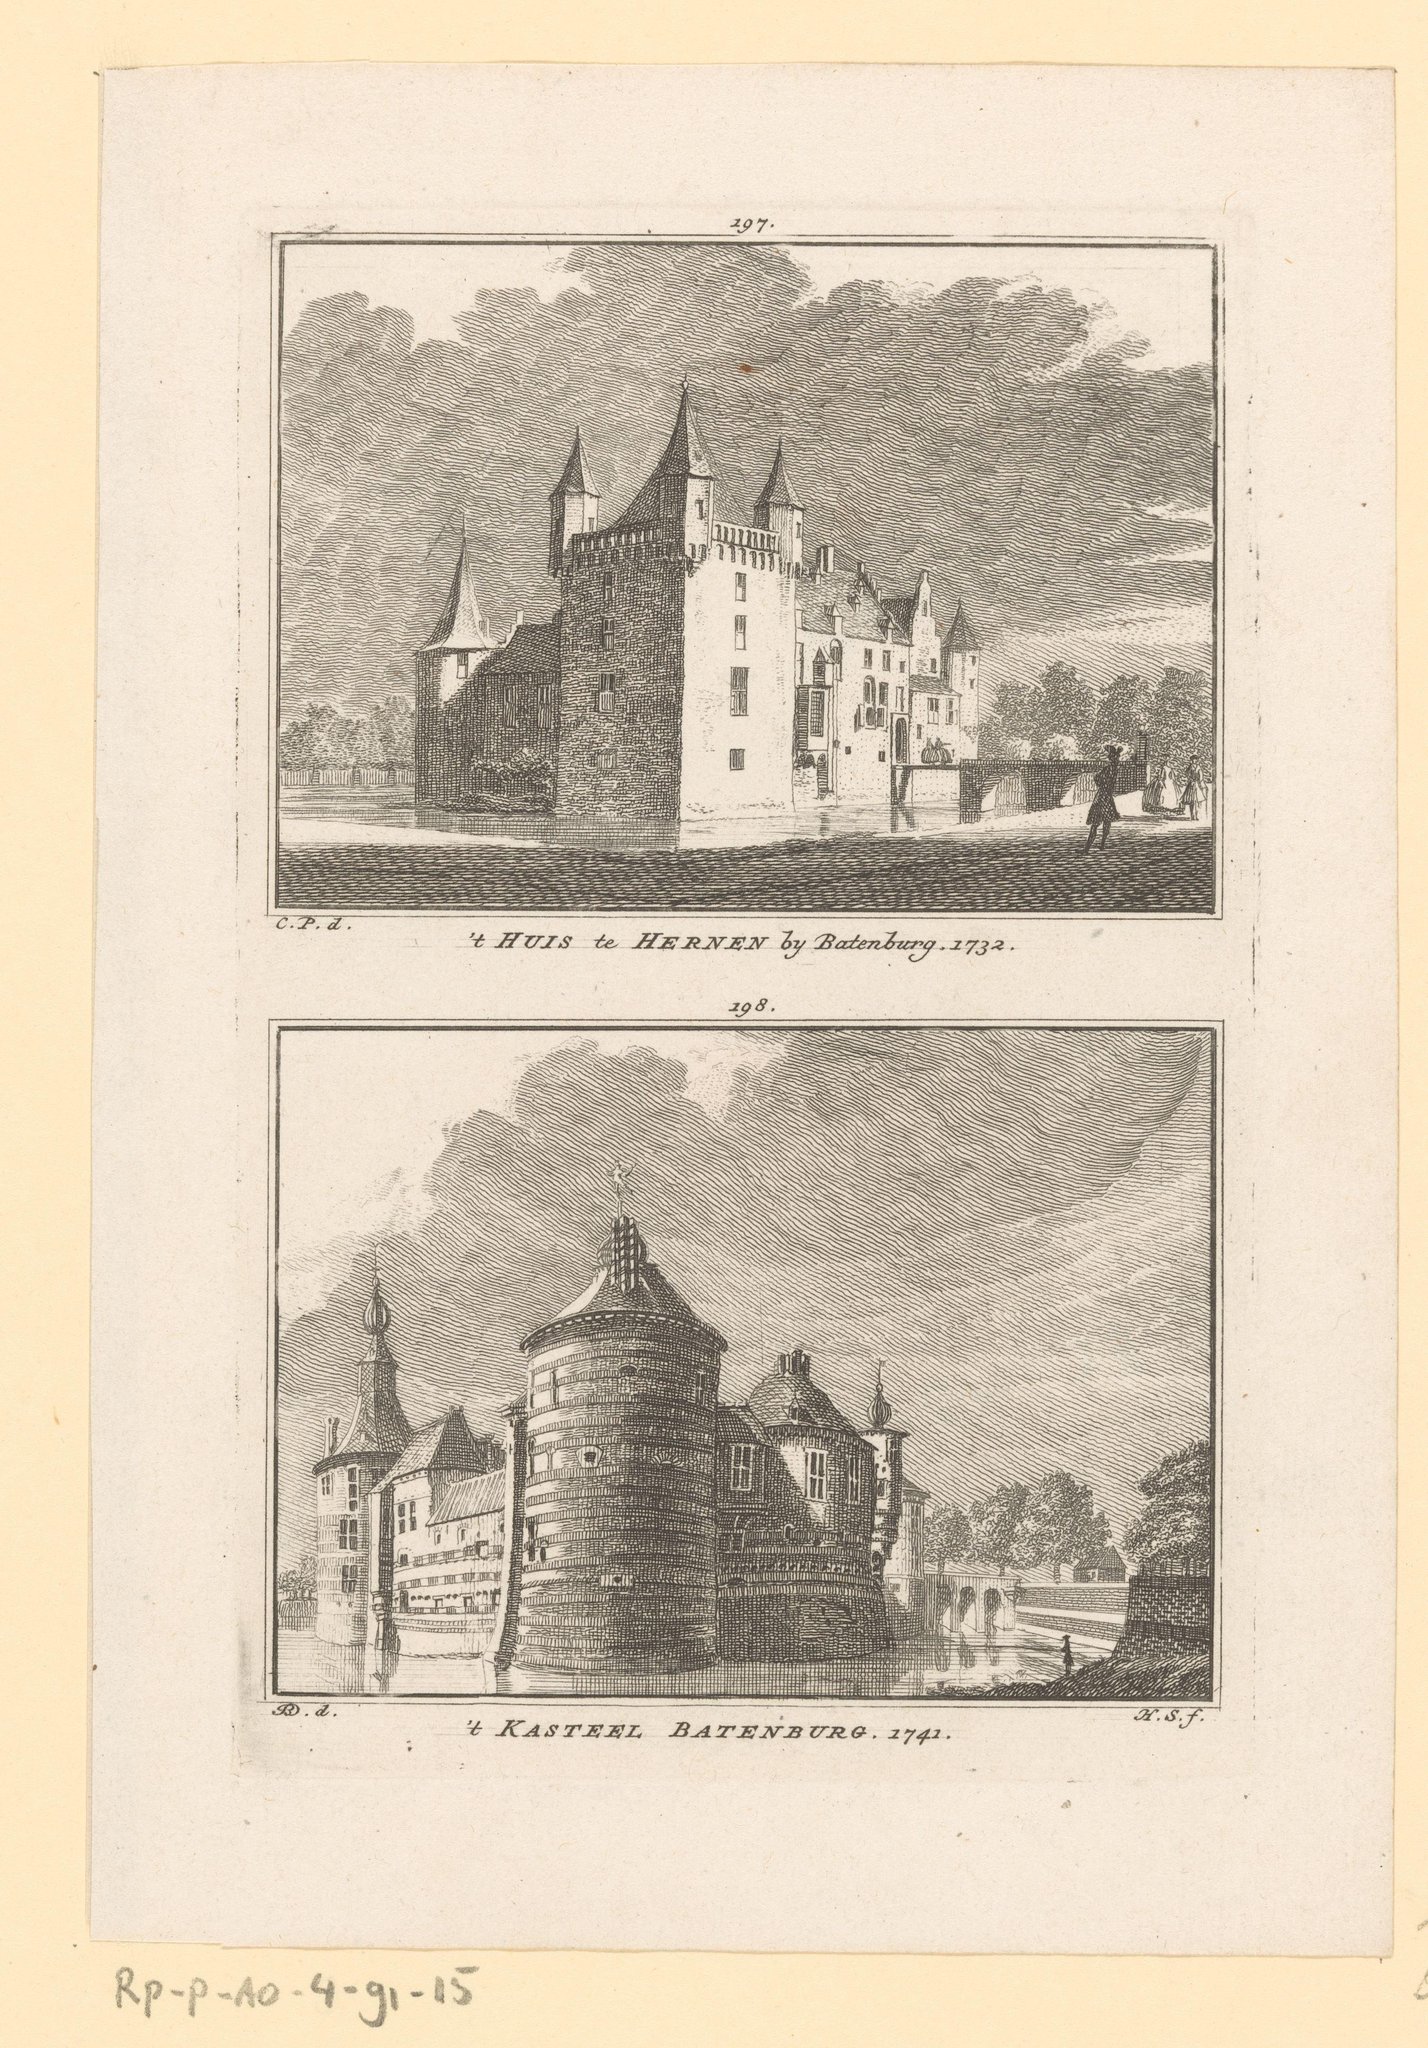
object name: print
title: Gezicht op Kasteel Hernen en Kasteel Batenburg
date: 1746-1792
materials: paper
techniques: etching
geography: haarlem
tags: castle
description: Prent ook gebruikt in: Het verheerlykt Nederland of kabinet van hedendaagsche gezigten van steden, dorpen (…). 9 delen. Amsterdam: Isaak Tirion en weduwe Isaak Tirion, 1745-1774, dl. 2 (1746), ill. 197-198. Of in: Nederlandsche tafereelen; of eene keurige verzameling van negen honderd fraaije gezigten van steden, dorpen, sloten, oudheden (….). 9 delen. Amsterdam: Jan de Groot, 1792, dl. 2, ill. 197-198.